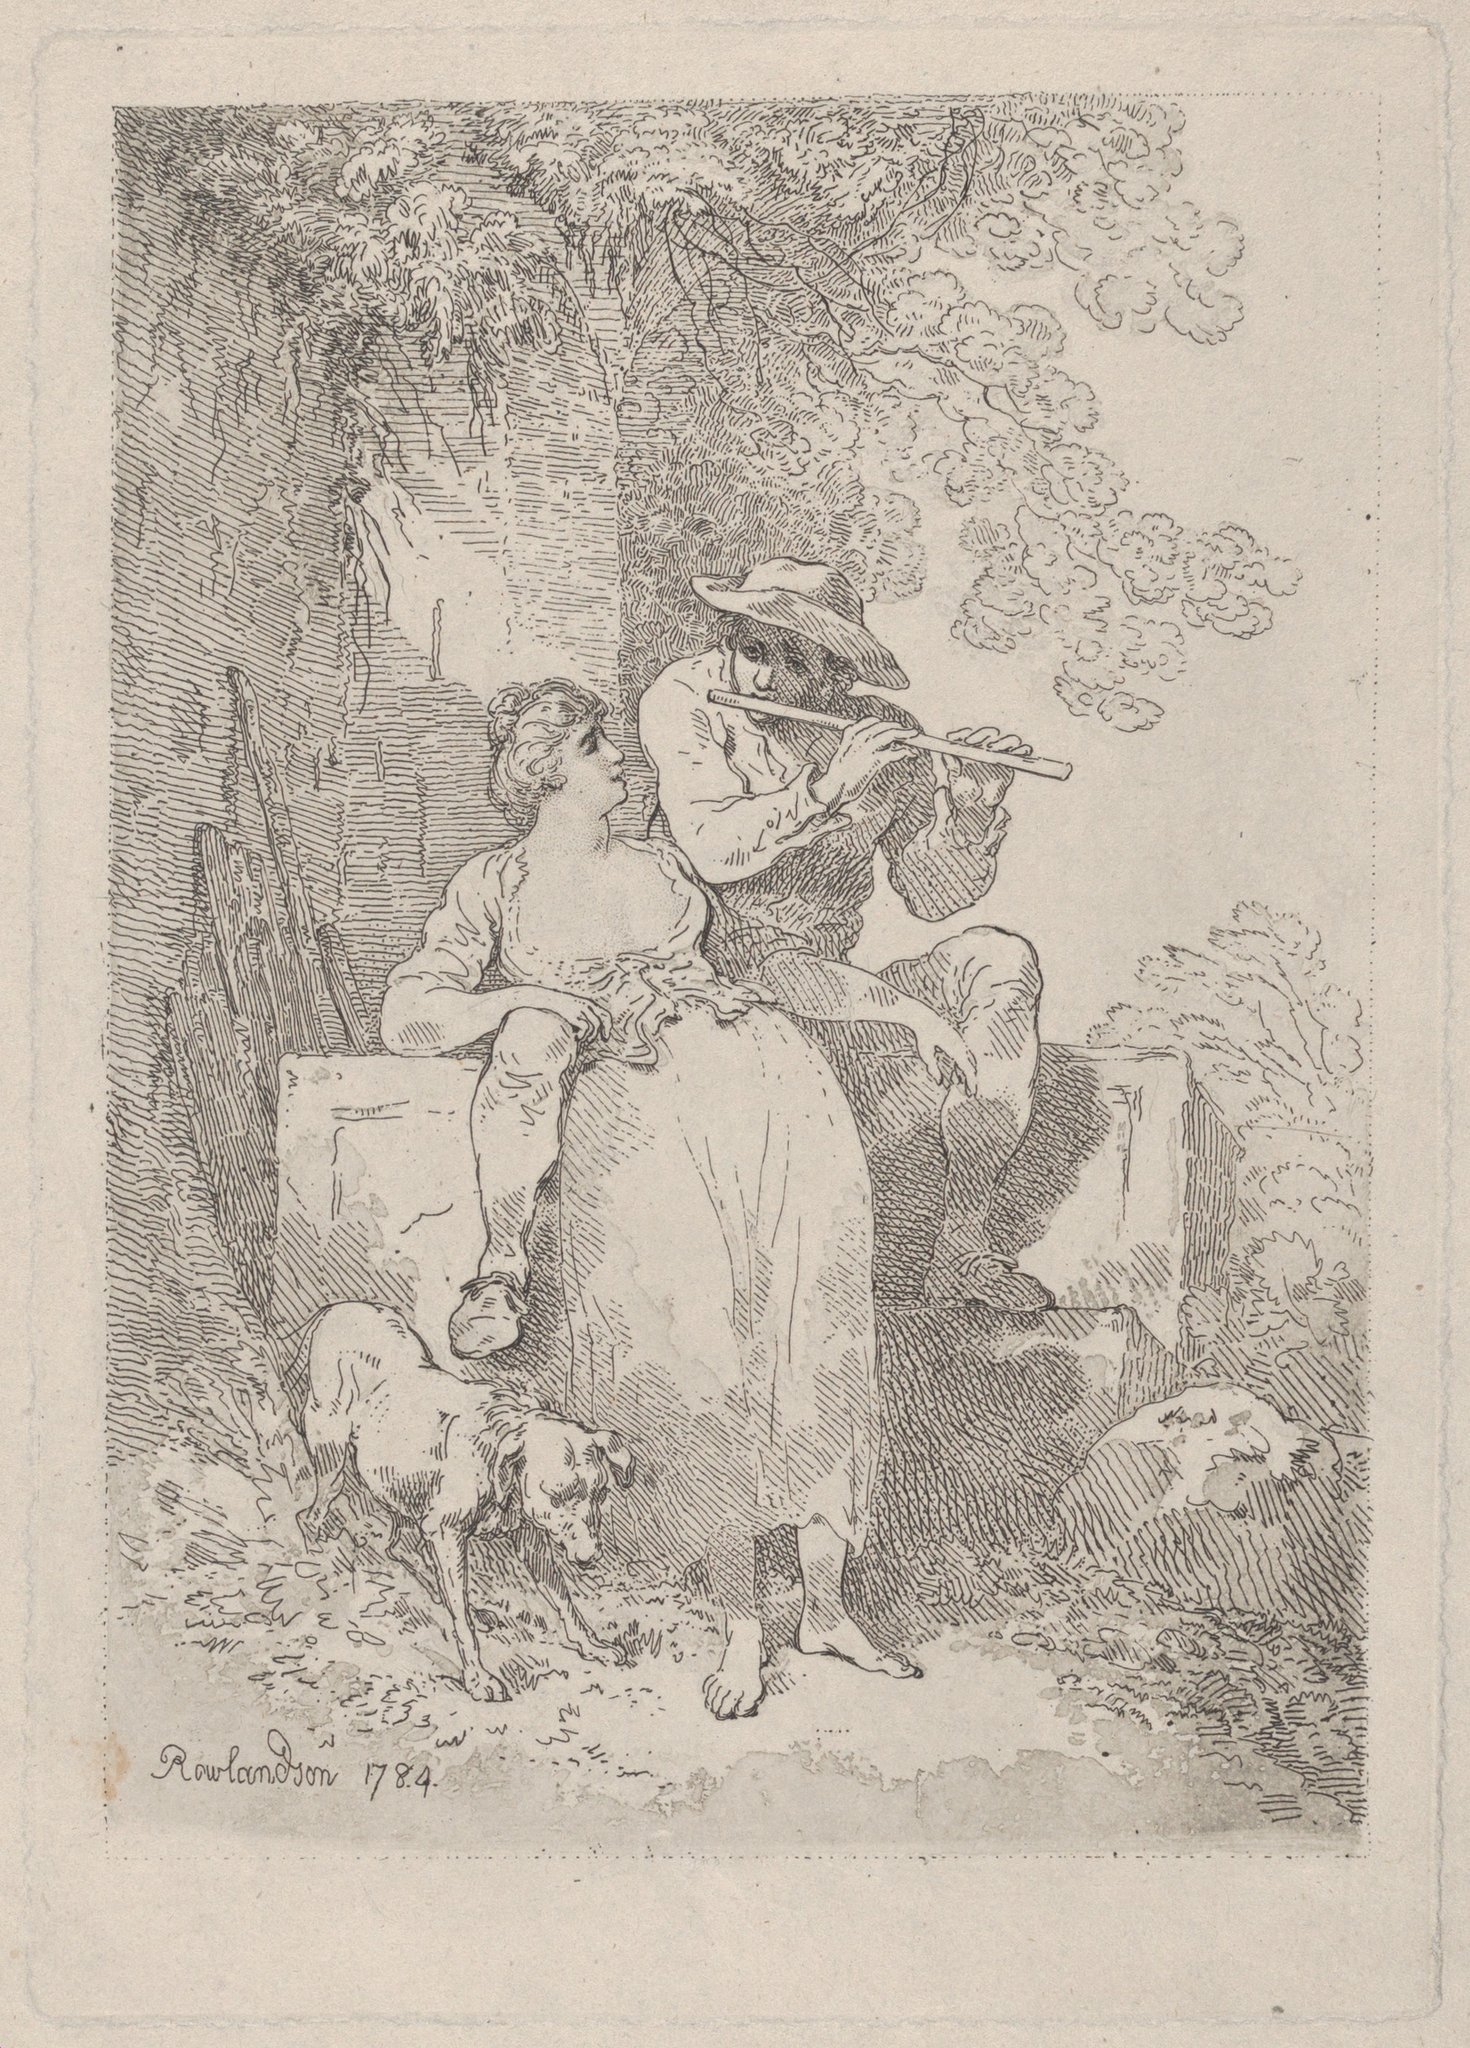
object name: print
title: Rest from Labour on Sunny Days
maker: thomas rowlandson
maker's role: artist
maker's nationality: british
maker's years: 1757-1827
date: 1784-1787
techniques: aquatint, etching, stippling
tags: men,women,flutes,dogs,musicians